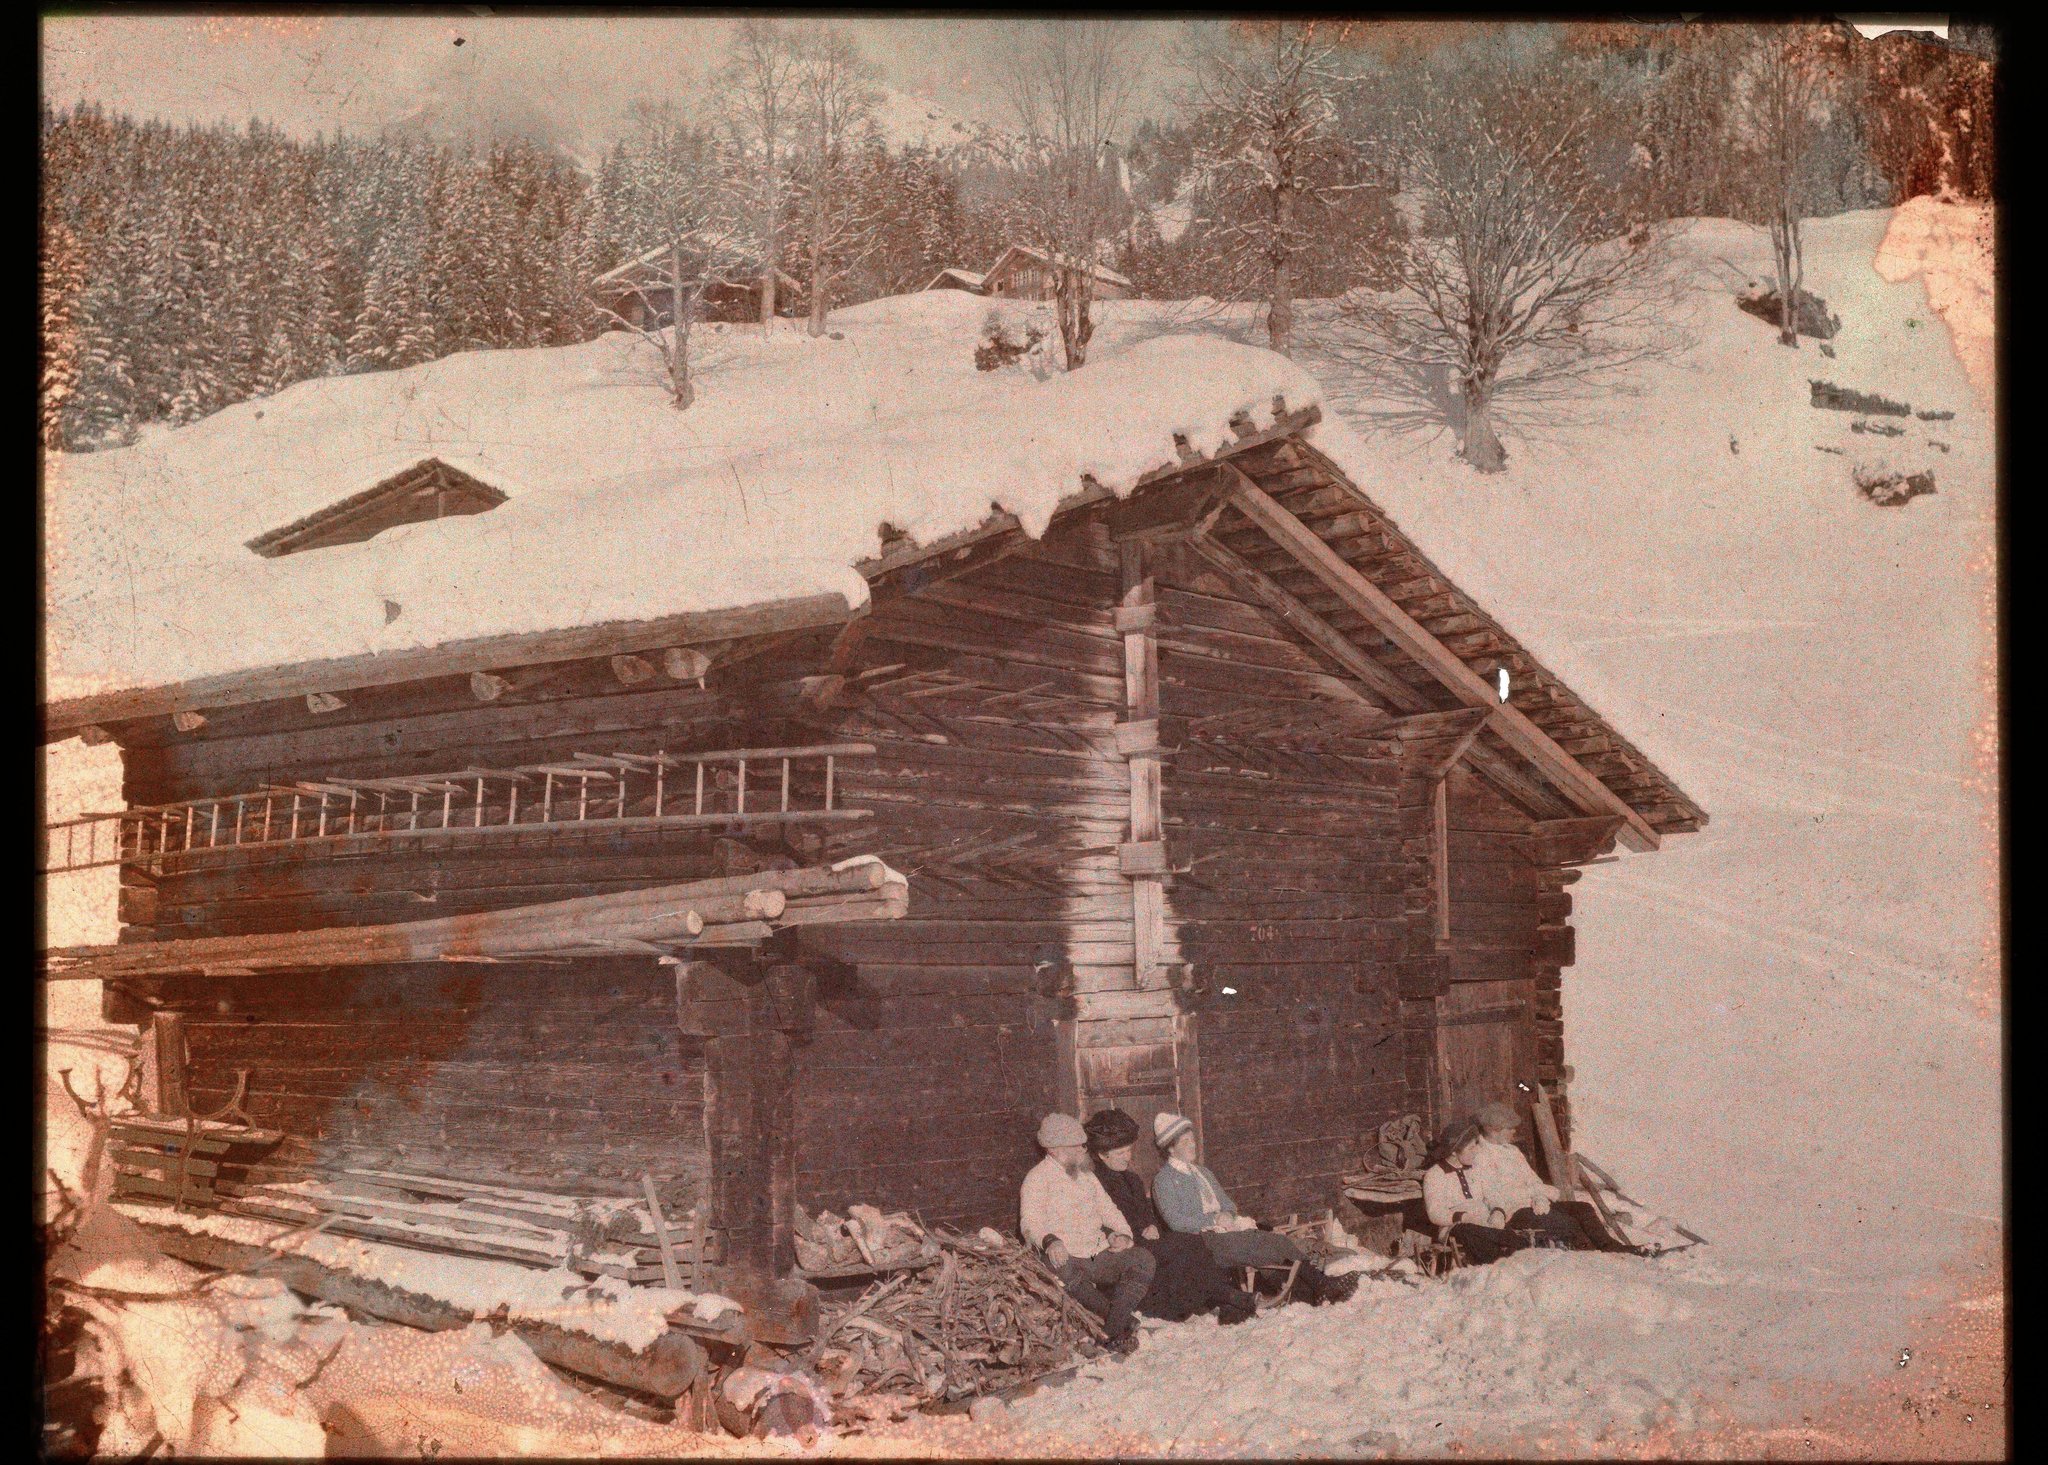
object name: color slide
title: Een hut in de sneeuw, met vijf zittende figuren ervoor zittend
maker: adolphe burdet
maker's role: fotograaf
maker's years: 1860-1940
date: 1907-1930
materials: glass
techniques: autochrome process, slide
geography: netherlands